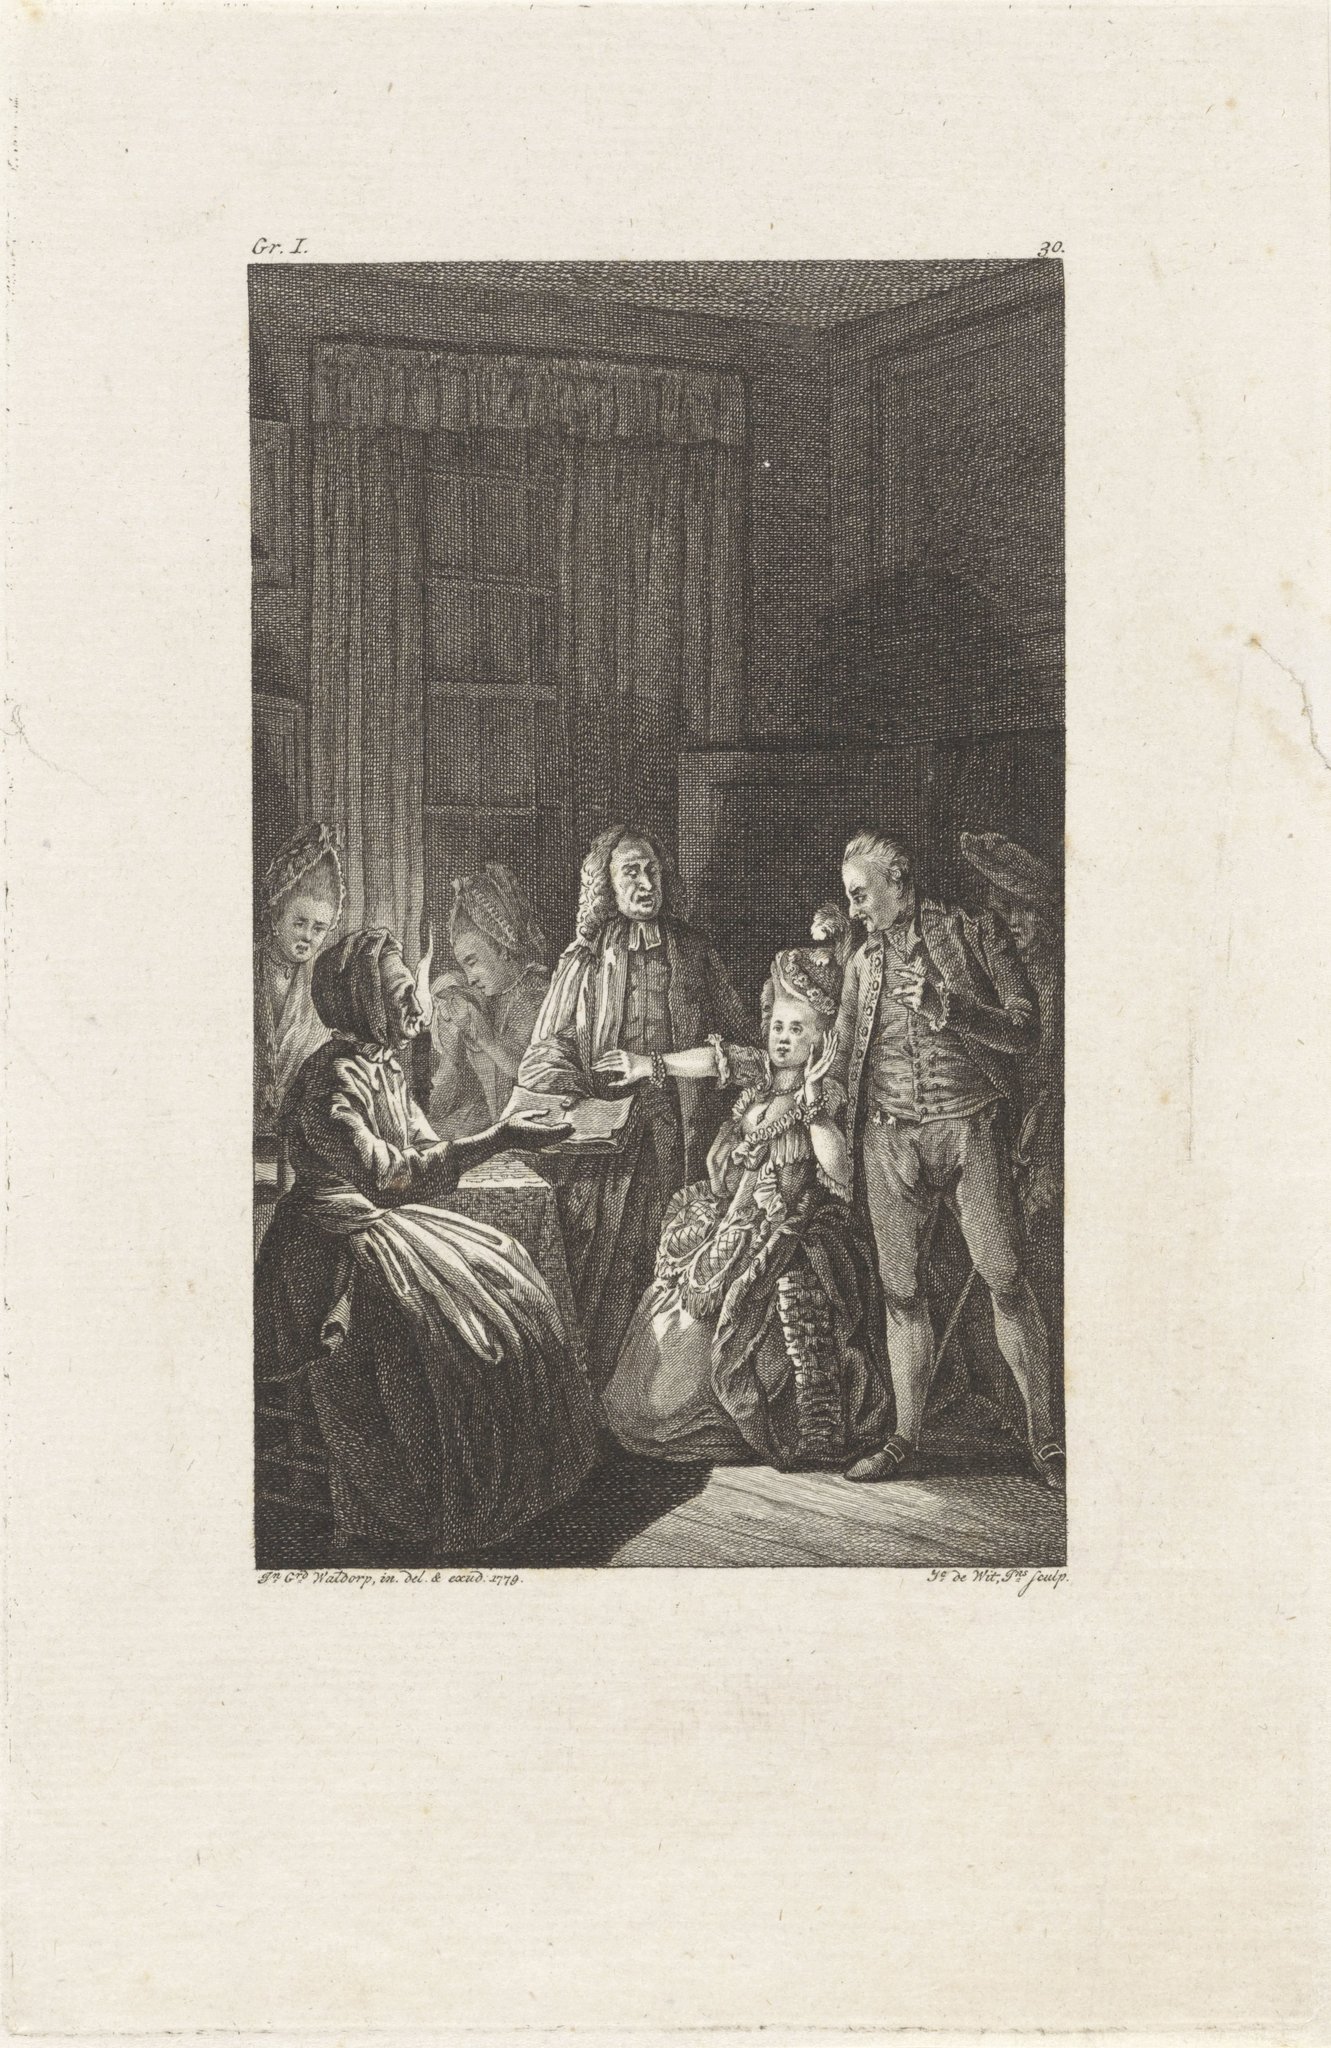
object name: book illustration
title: Interieur met figuren bij kaarslicht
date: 1779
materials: paper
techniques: etching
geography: amsterdam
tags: candle, communal rooms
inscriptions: collector's mark: Lugt 240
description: Een rijk geklede jonge vrouw wordt door twee heren op de knieën gedwongen, een van hen heeft een open boek vast. In de kamer nog drie andere vrouwen. Linksboevn: Gr. I en rechtsboven: 30.